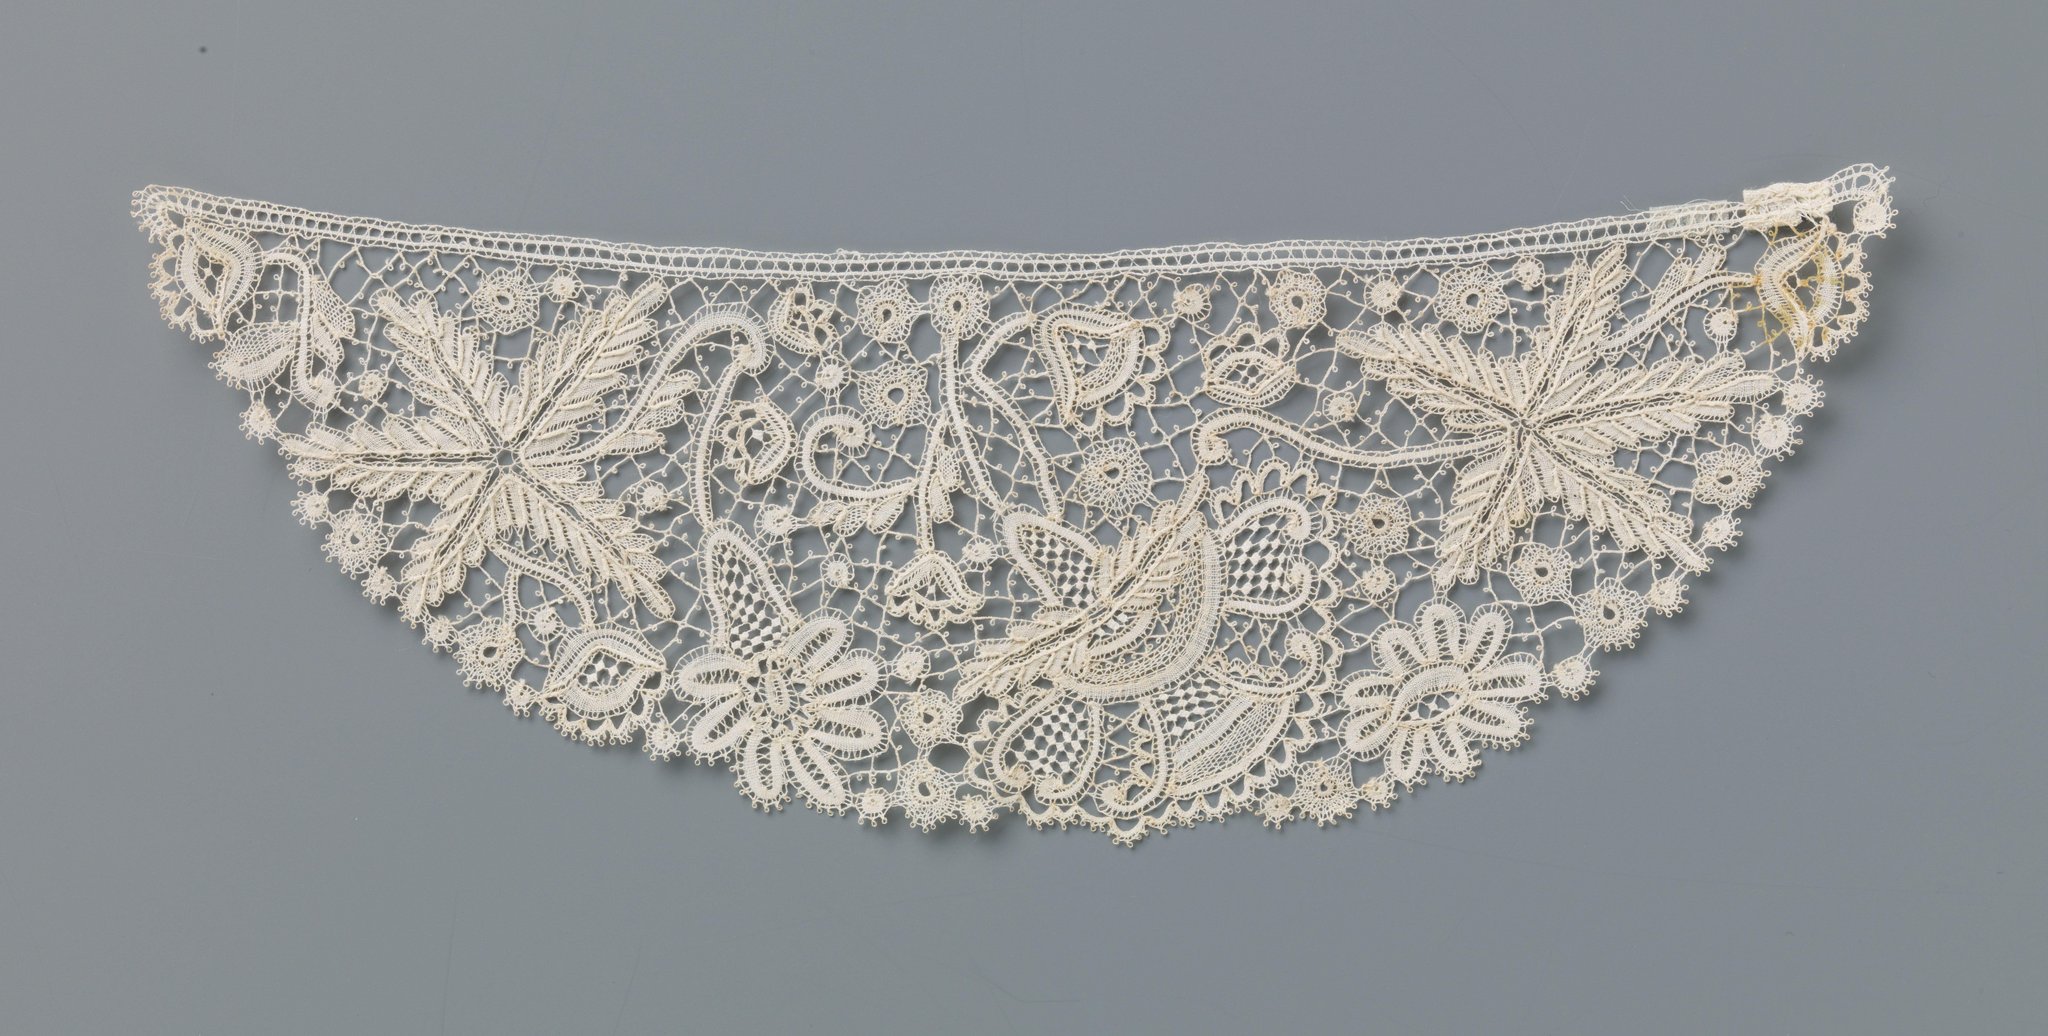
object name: cuff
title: Manchet van kloskant versierd met drielobbige waaierbloemen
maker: martha berkers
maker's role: kantwerkster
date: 1915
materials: linen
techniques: lace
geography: sluis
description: Manchet van naturelkleurige kloskant, duchesse-kant. De manchet is als een cirkelsegment gevormd. Een zeer fijn symmetrisch dessin staat op een fond van spijlen. Een grote kelkbloem en een stervormig vijfblad wisselen af met een grote waaiervormige bloem, die is opgebouwd uit een kelk met een halve cirkel als hart en drie uitstralende lobben. Klein strooigoed van kelkjes, rozetjes en pailletten dient als opvulling. Bijna strakke buitenkanten, bestaande uit fijne bloempjes.